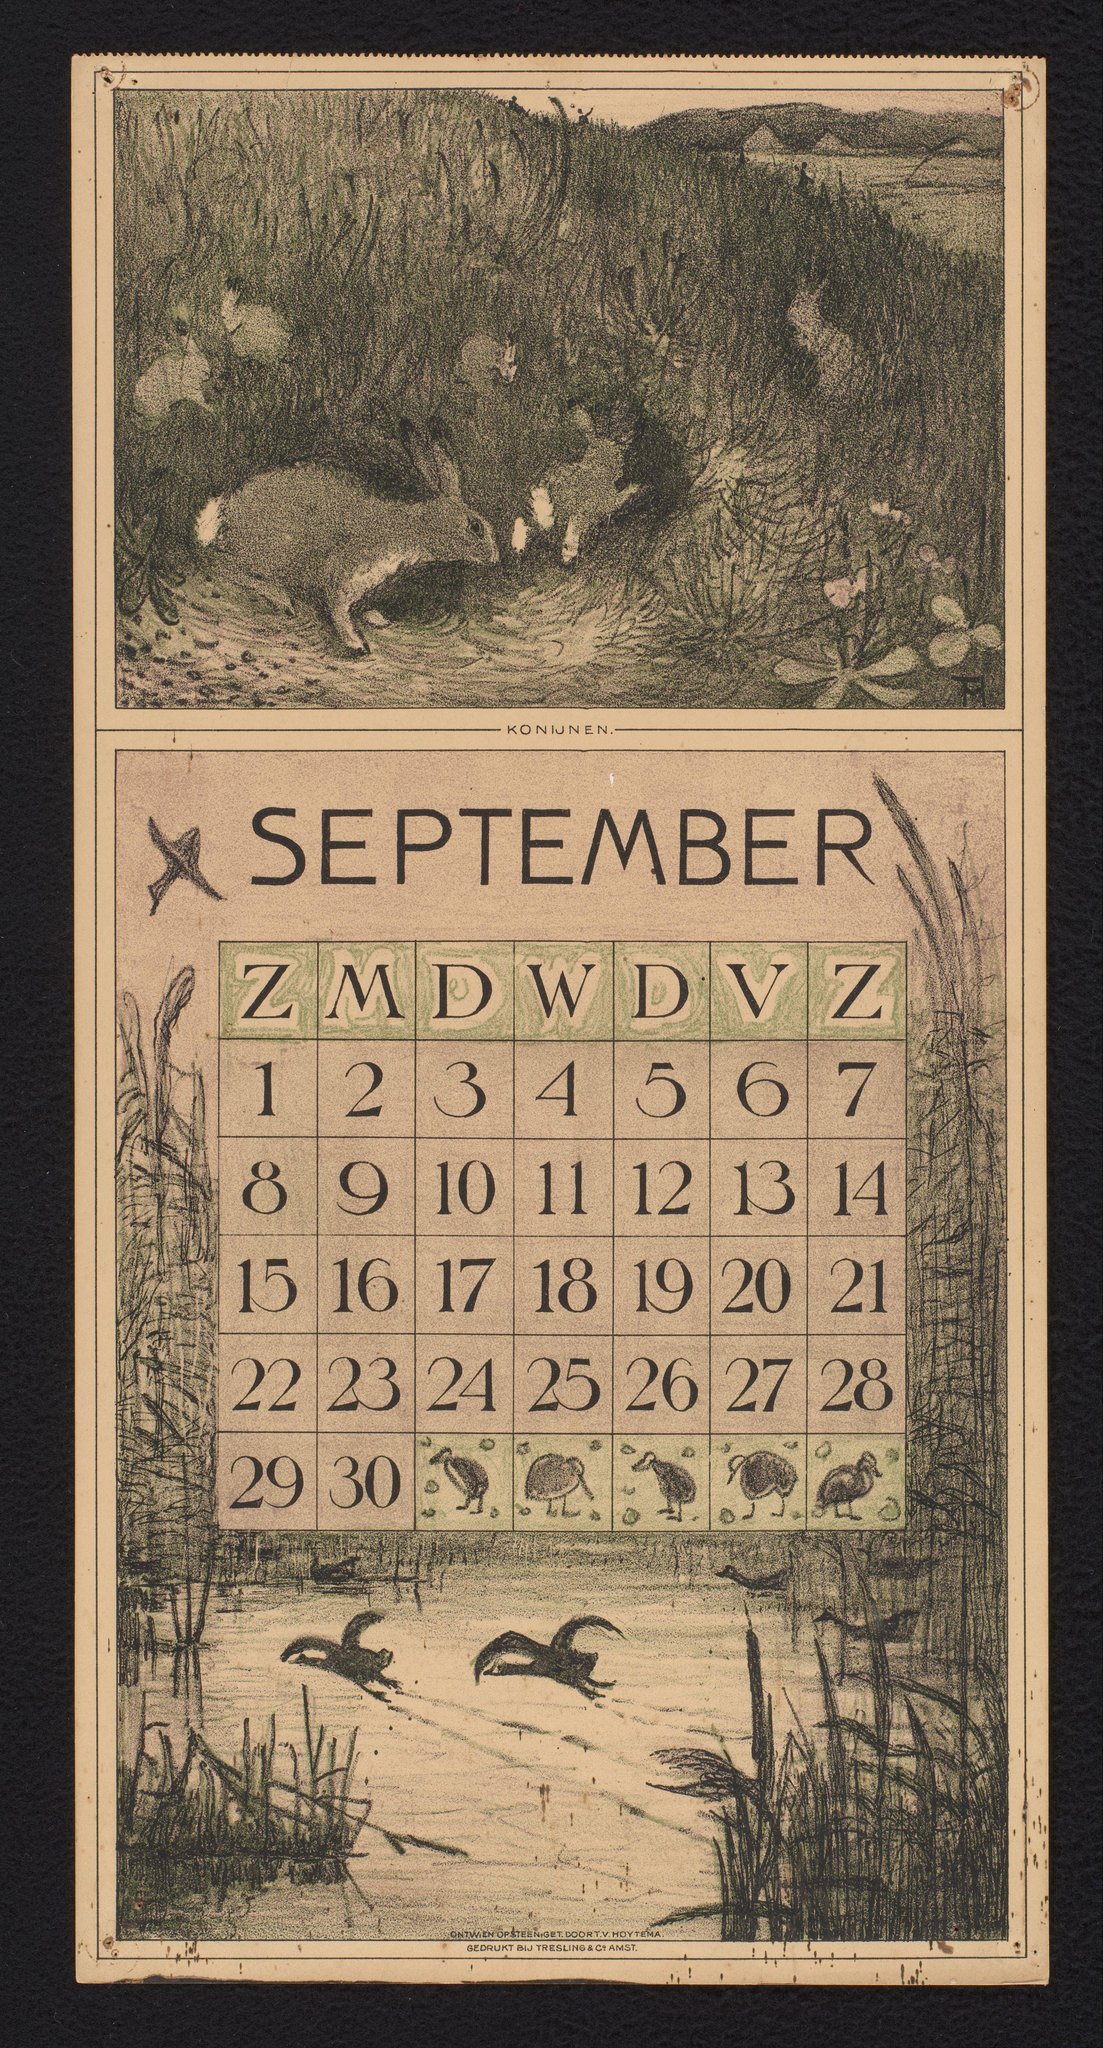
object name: calendar leaf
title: Kalenderblad voor september 1912 met konijnen en meerkoeten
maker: theo van hoytema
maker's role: draughtsman, painter, print maker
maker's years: 1863-1917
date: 1911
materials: paper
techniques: lithograph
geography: amsterdam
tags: calendar, almanac, shore-birds and wading-birds, rodents: rabbit